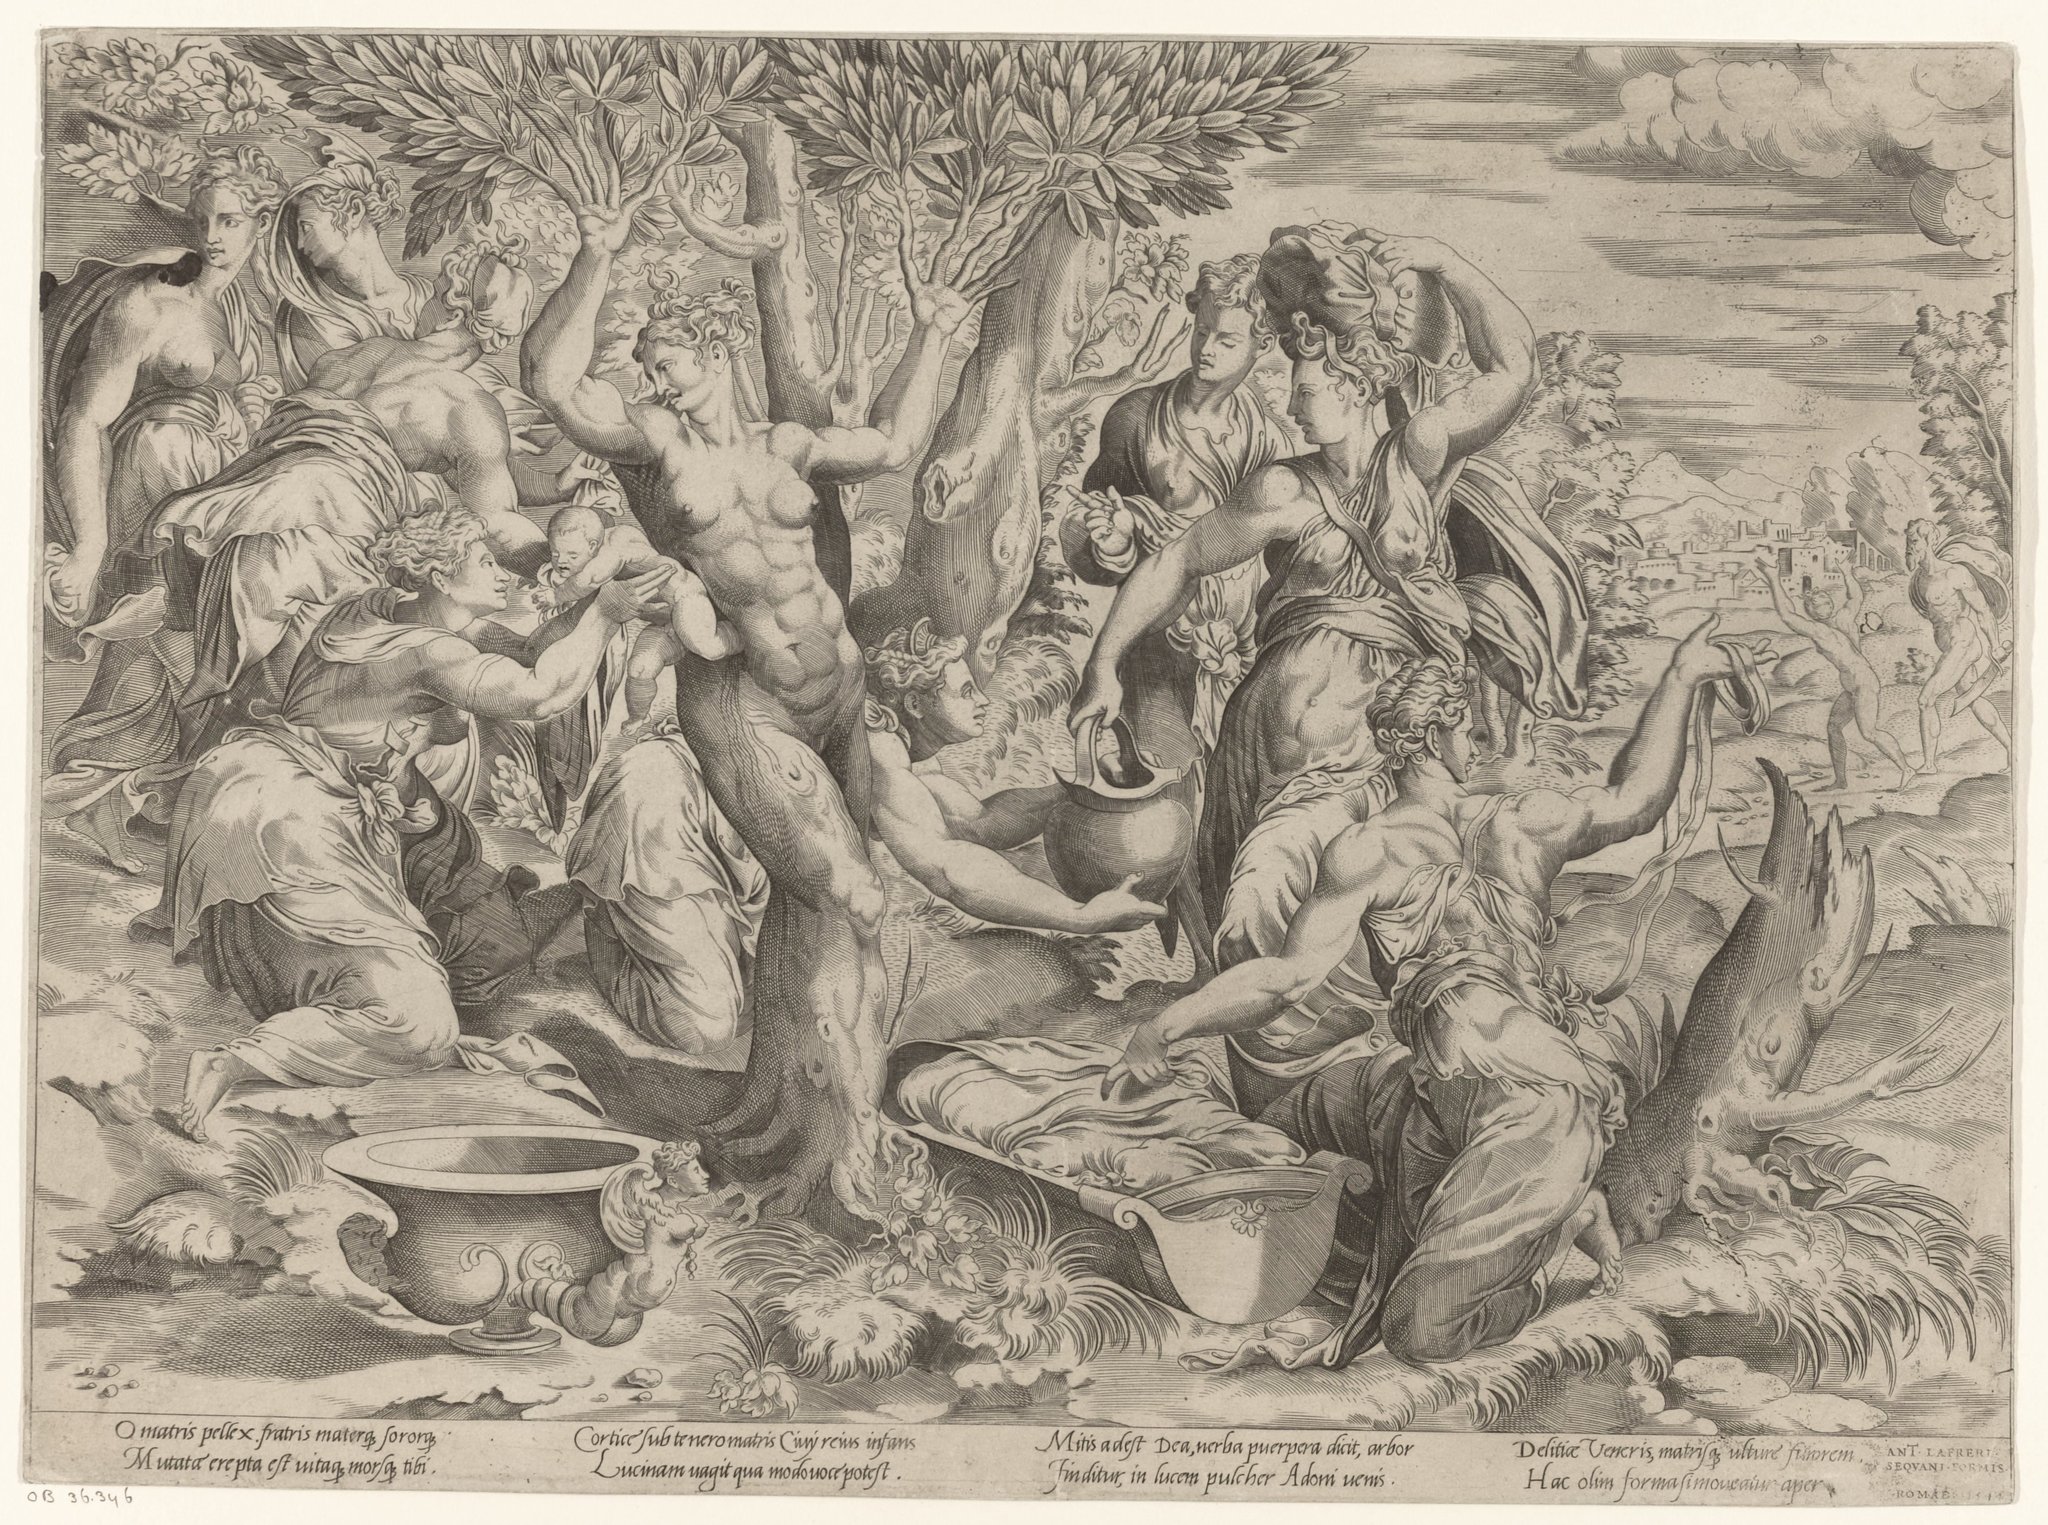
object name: print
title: Geboorte van Adonis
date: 1544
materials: paper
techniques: engraving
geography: italy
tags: birth of adonis: the tree splits open to release the baby; the naiads take care of him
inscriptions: collector's mark: Lugt 240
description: Adonis wordt geboren uit een spleet in de stam van een boom (half vrouw half boom). De boom is zijn moeder Myrrha, die na een incestueuze relatie met haar vader Cinyras werd veranderd in een boom. Rond de boom staan Myrrha's min Lucina en de nimfen die voor Adonis zorgen. In de ondermarge vers in het Latijn.